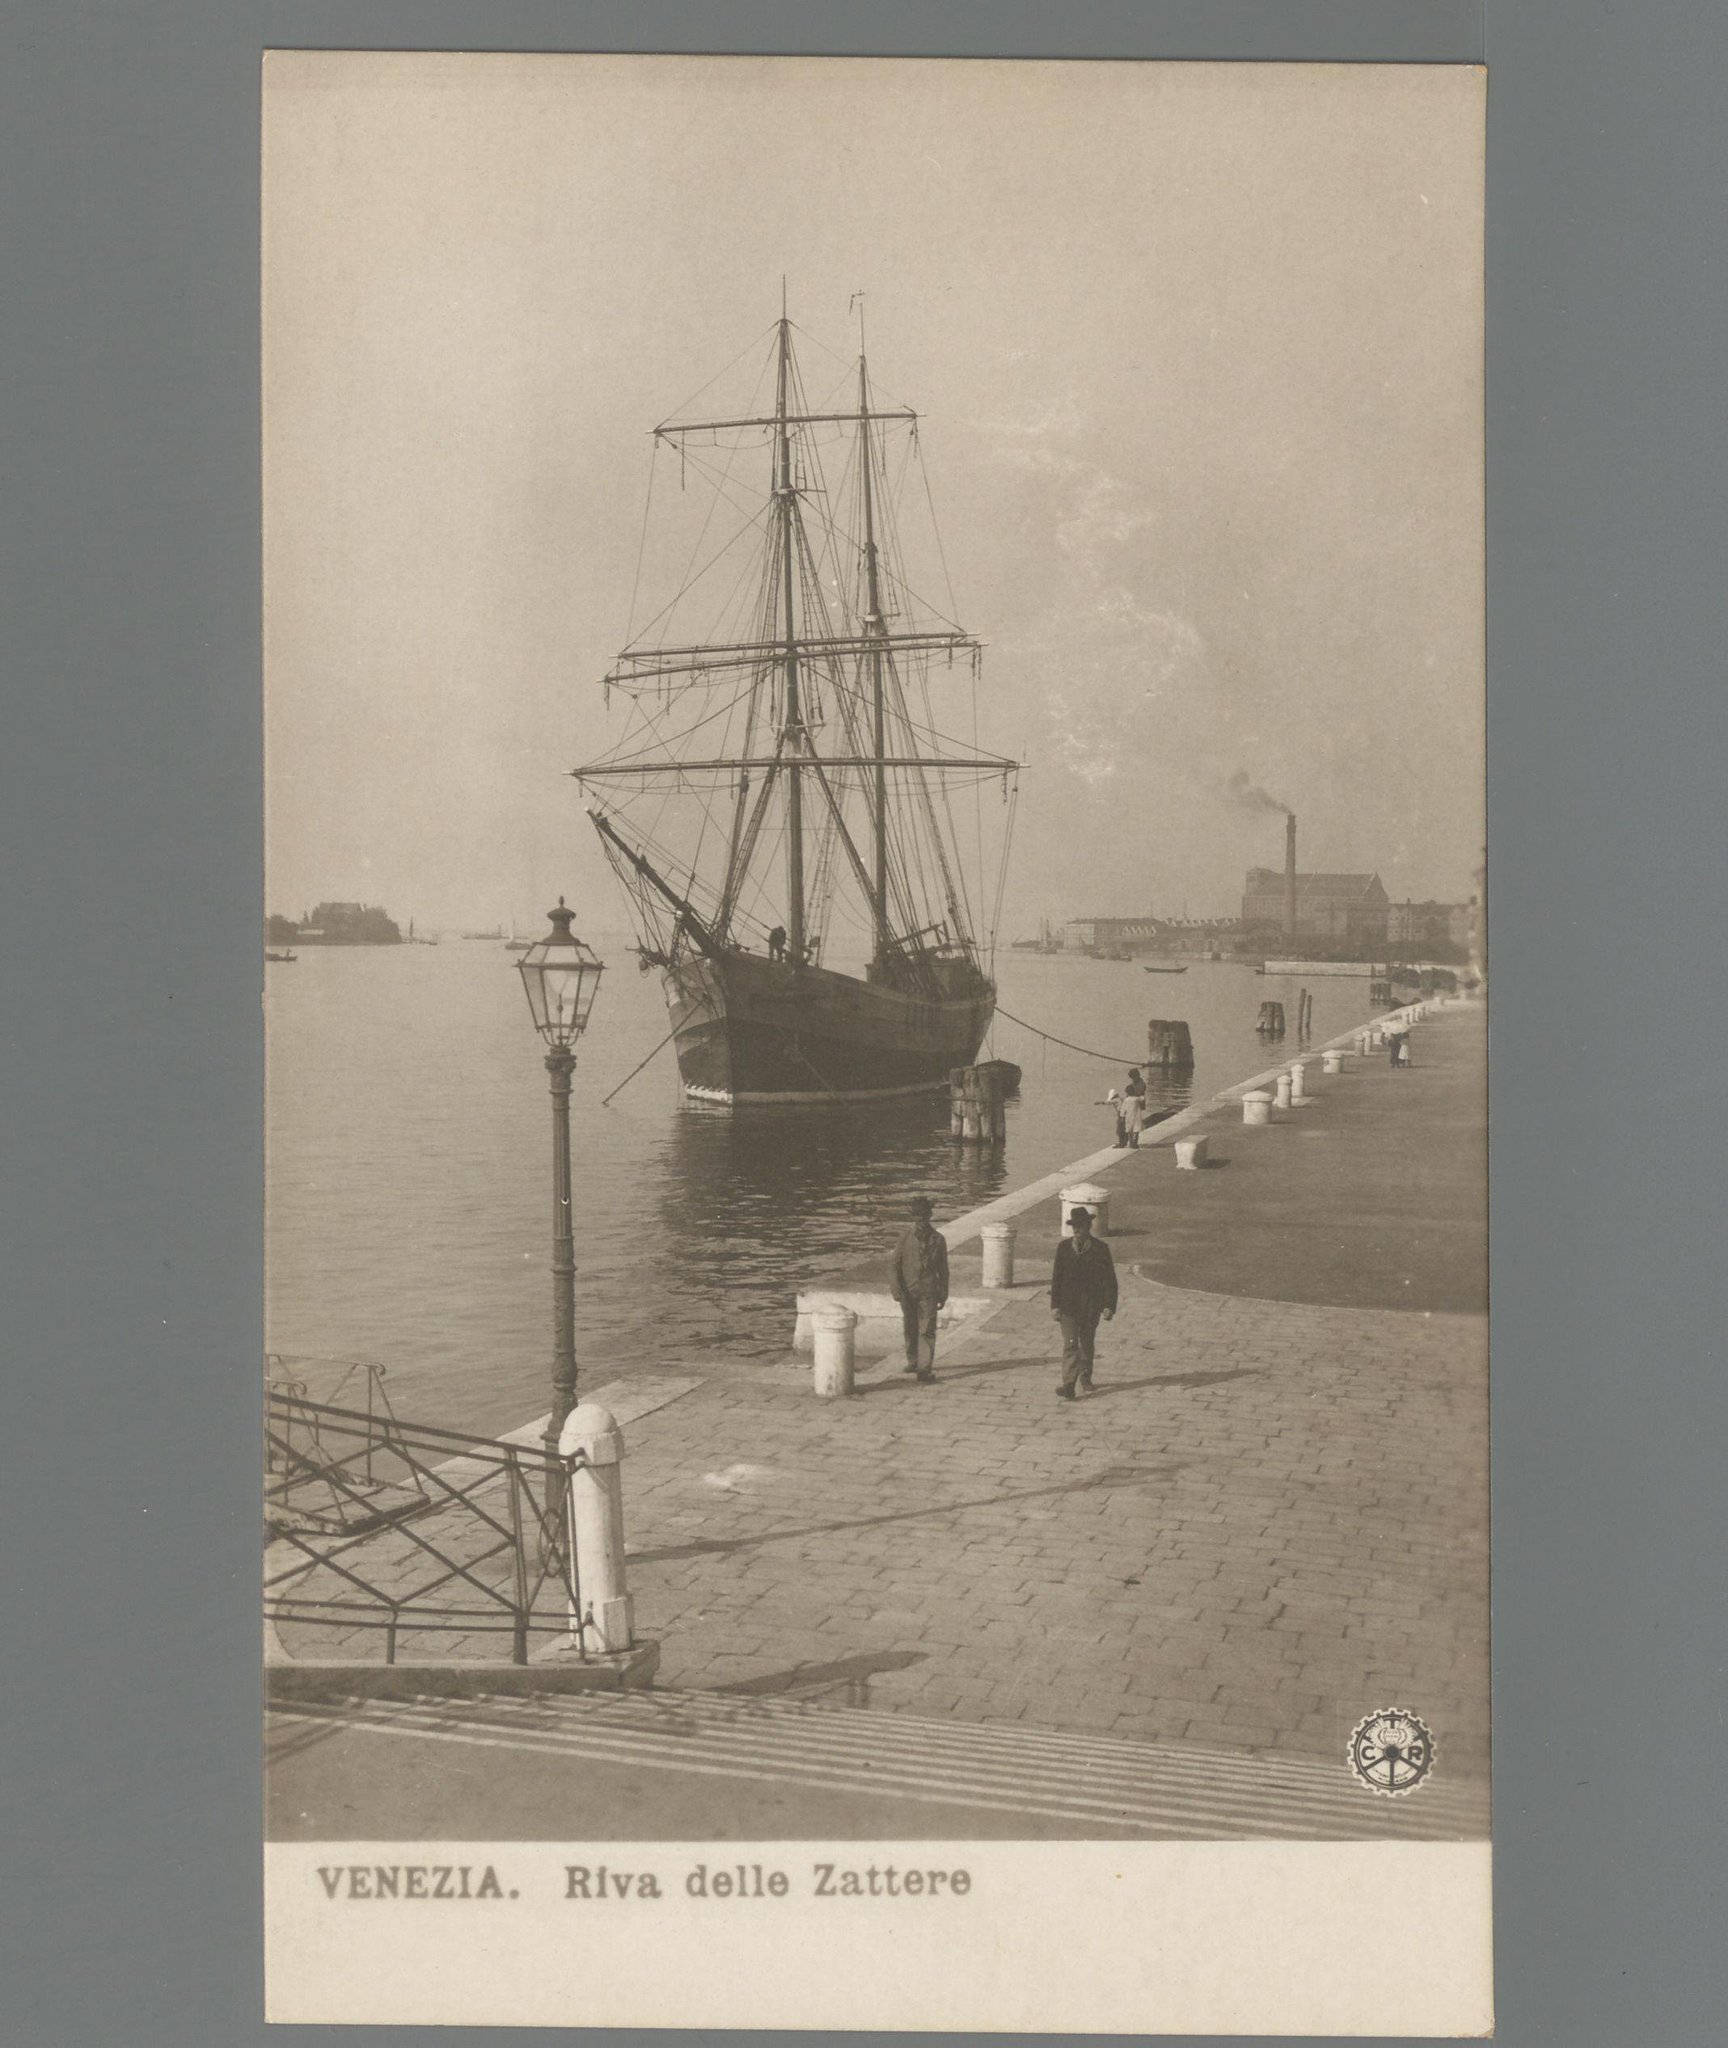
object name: ansichtkaart, prentbriefkaart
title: Venezia. Riva delle Zattere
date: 1900-1906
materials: photographic support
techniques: photography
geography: milan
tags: sailing-ship, sailing-boat, quay (+ city(-scape) with figures, staffage), venice